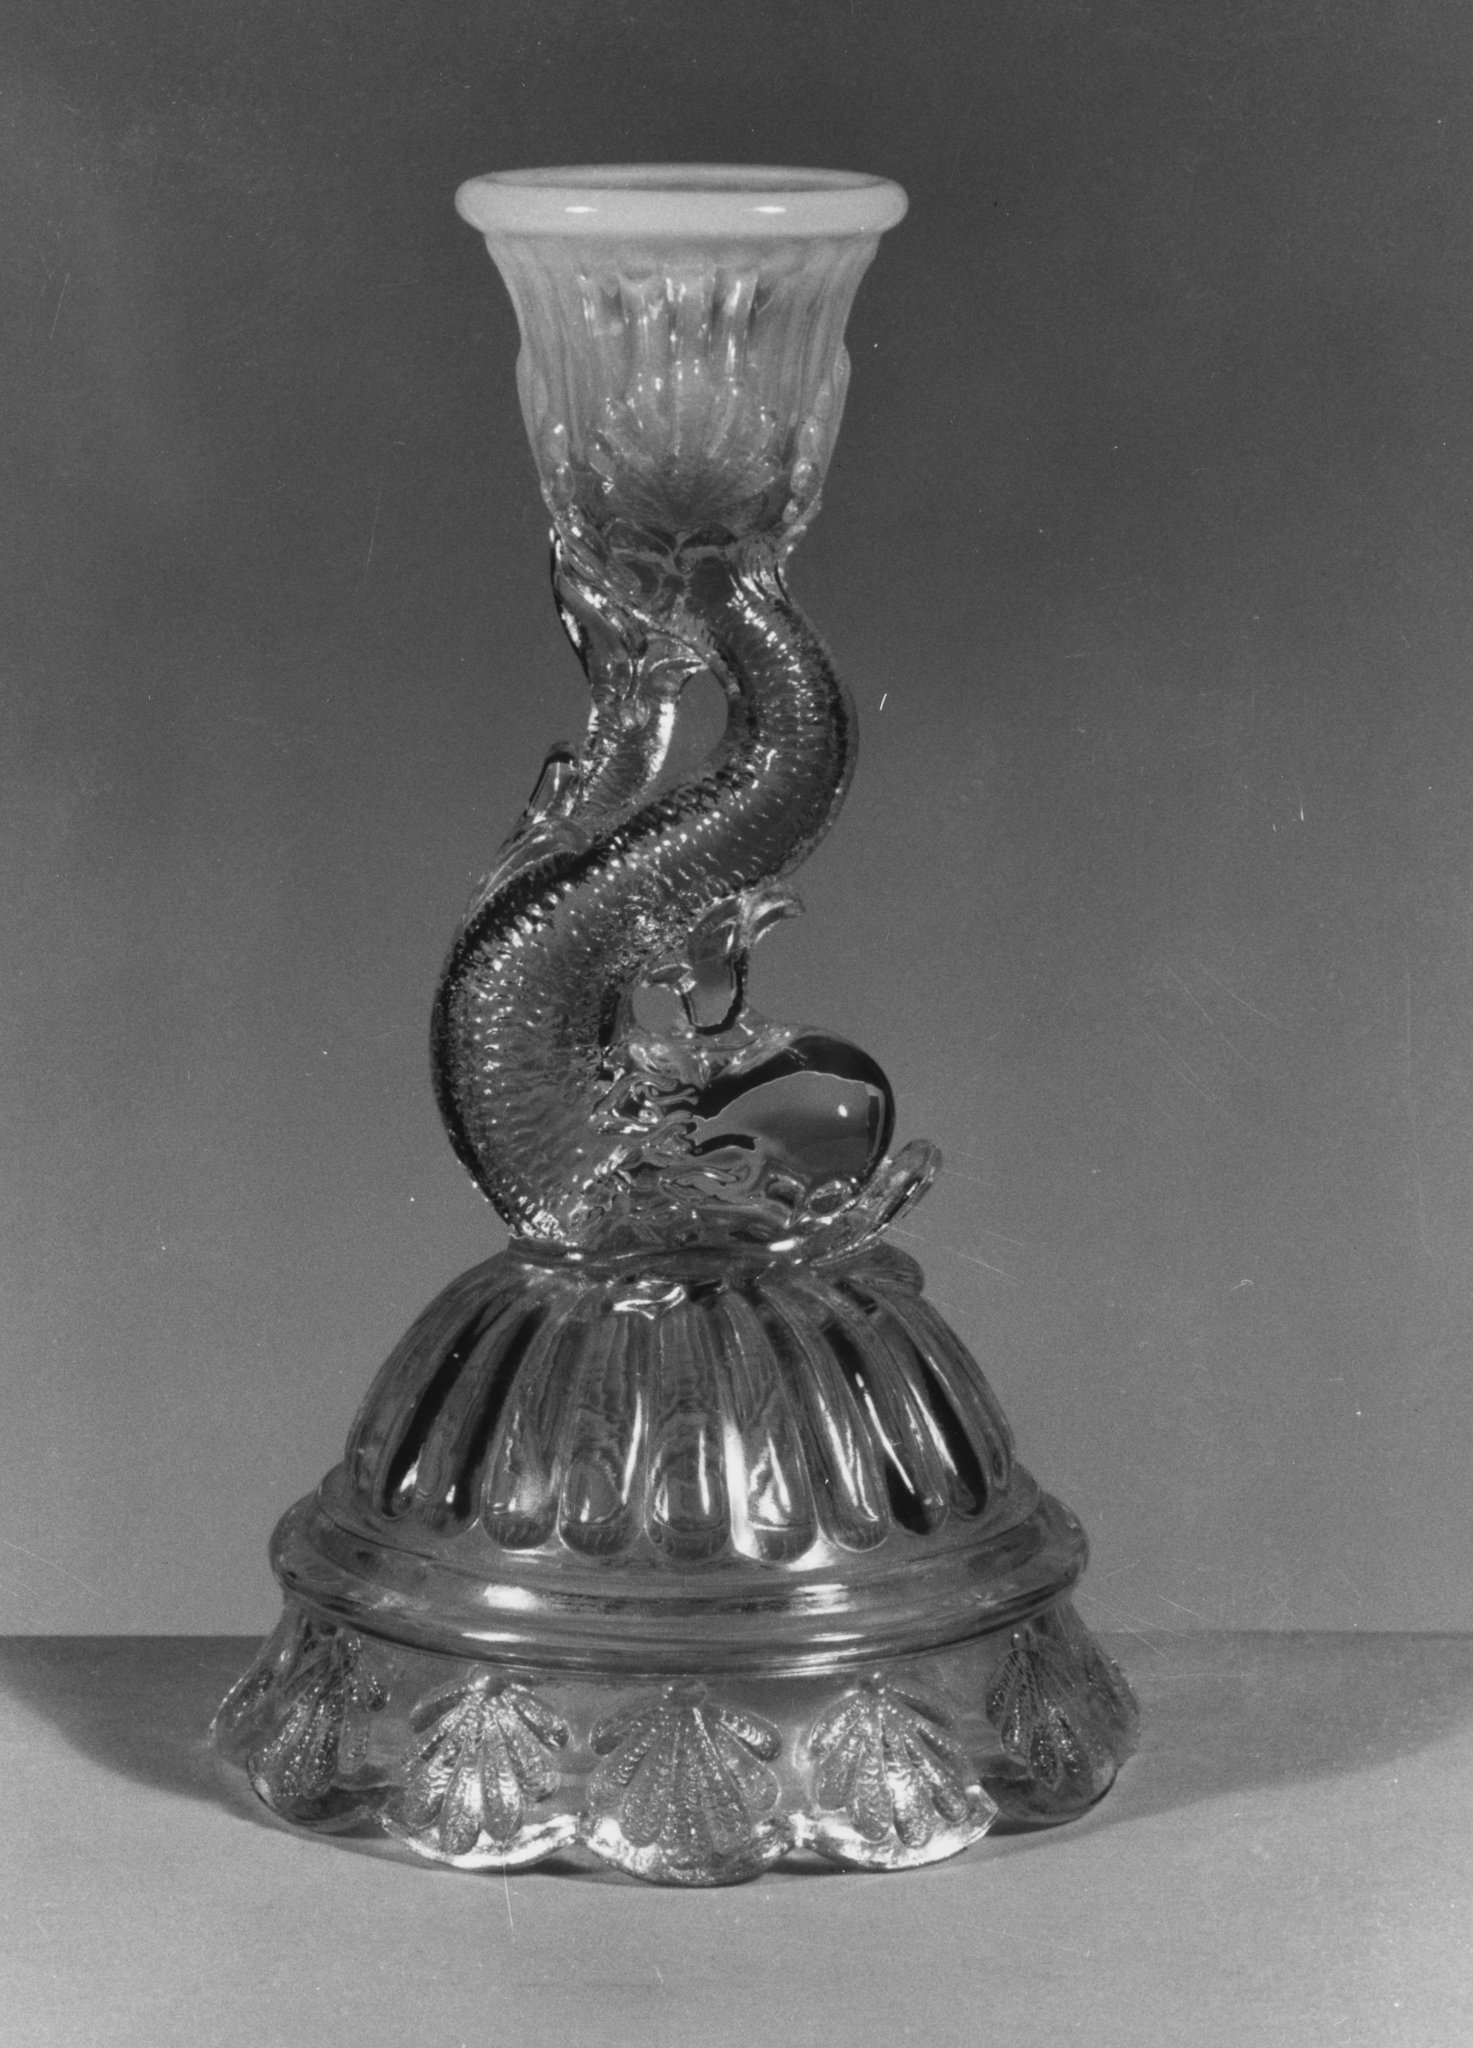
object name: candlestick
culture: american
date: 1875-1900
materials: glass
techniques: pressed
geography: united states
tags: dolphins